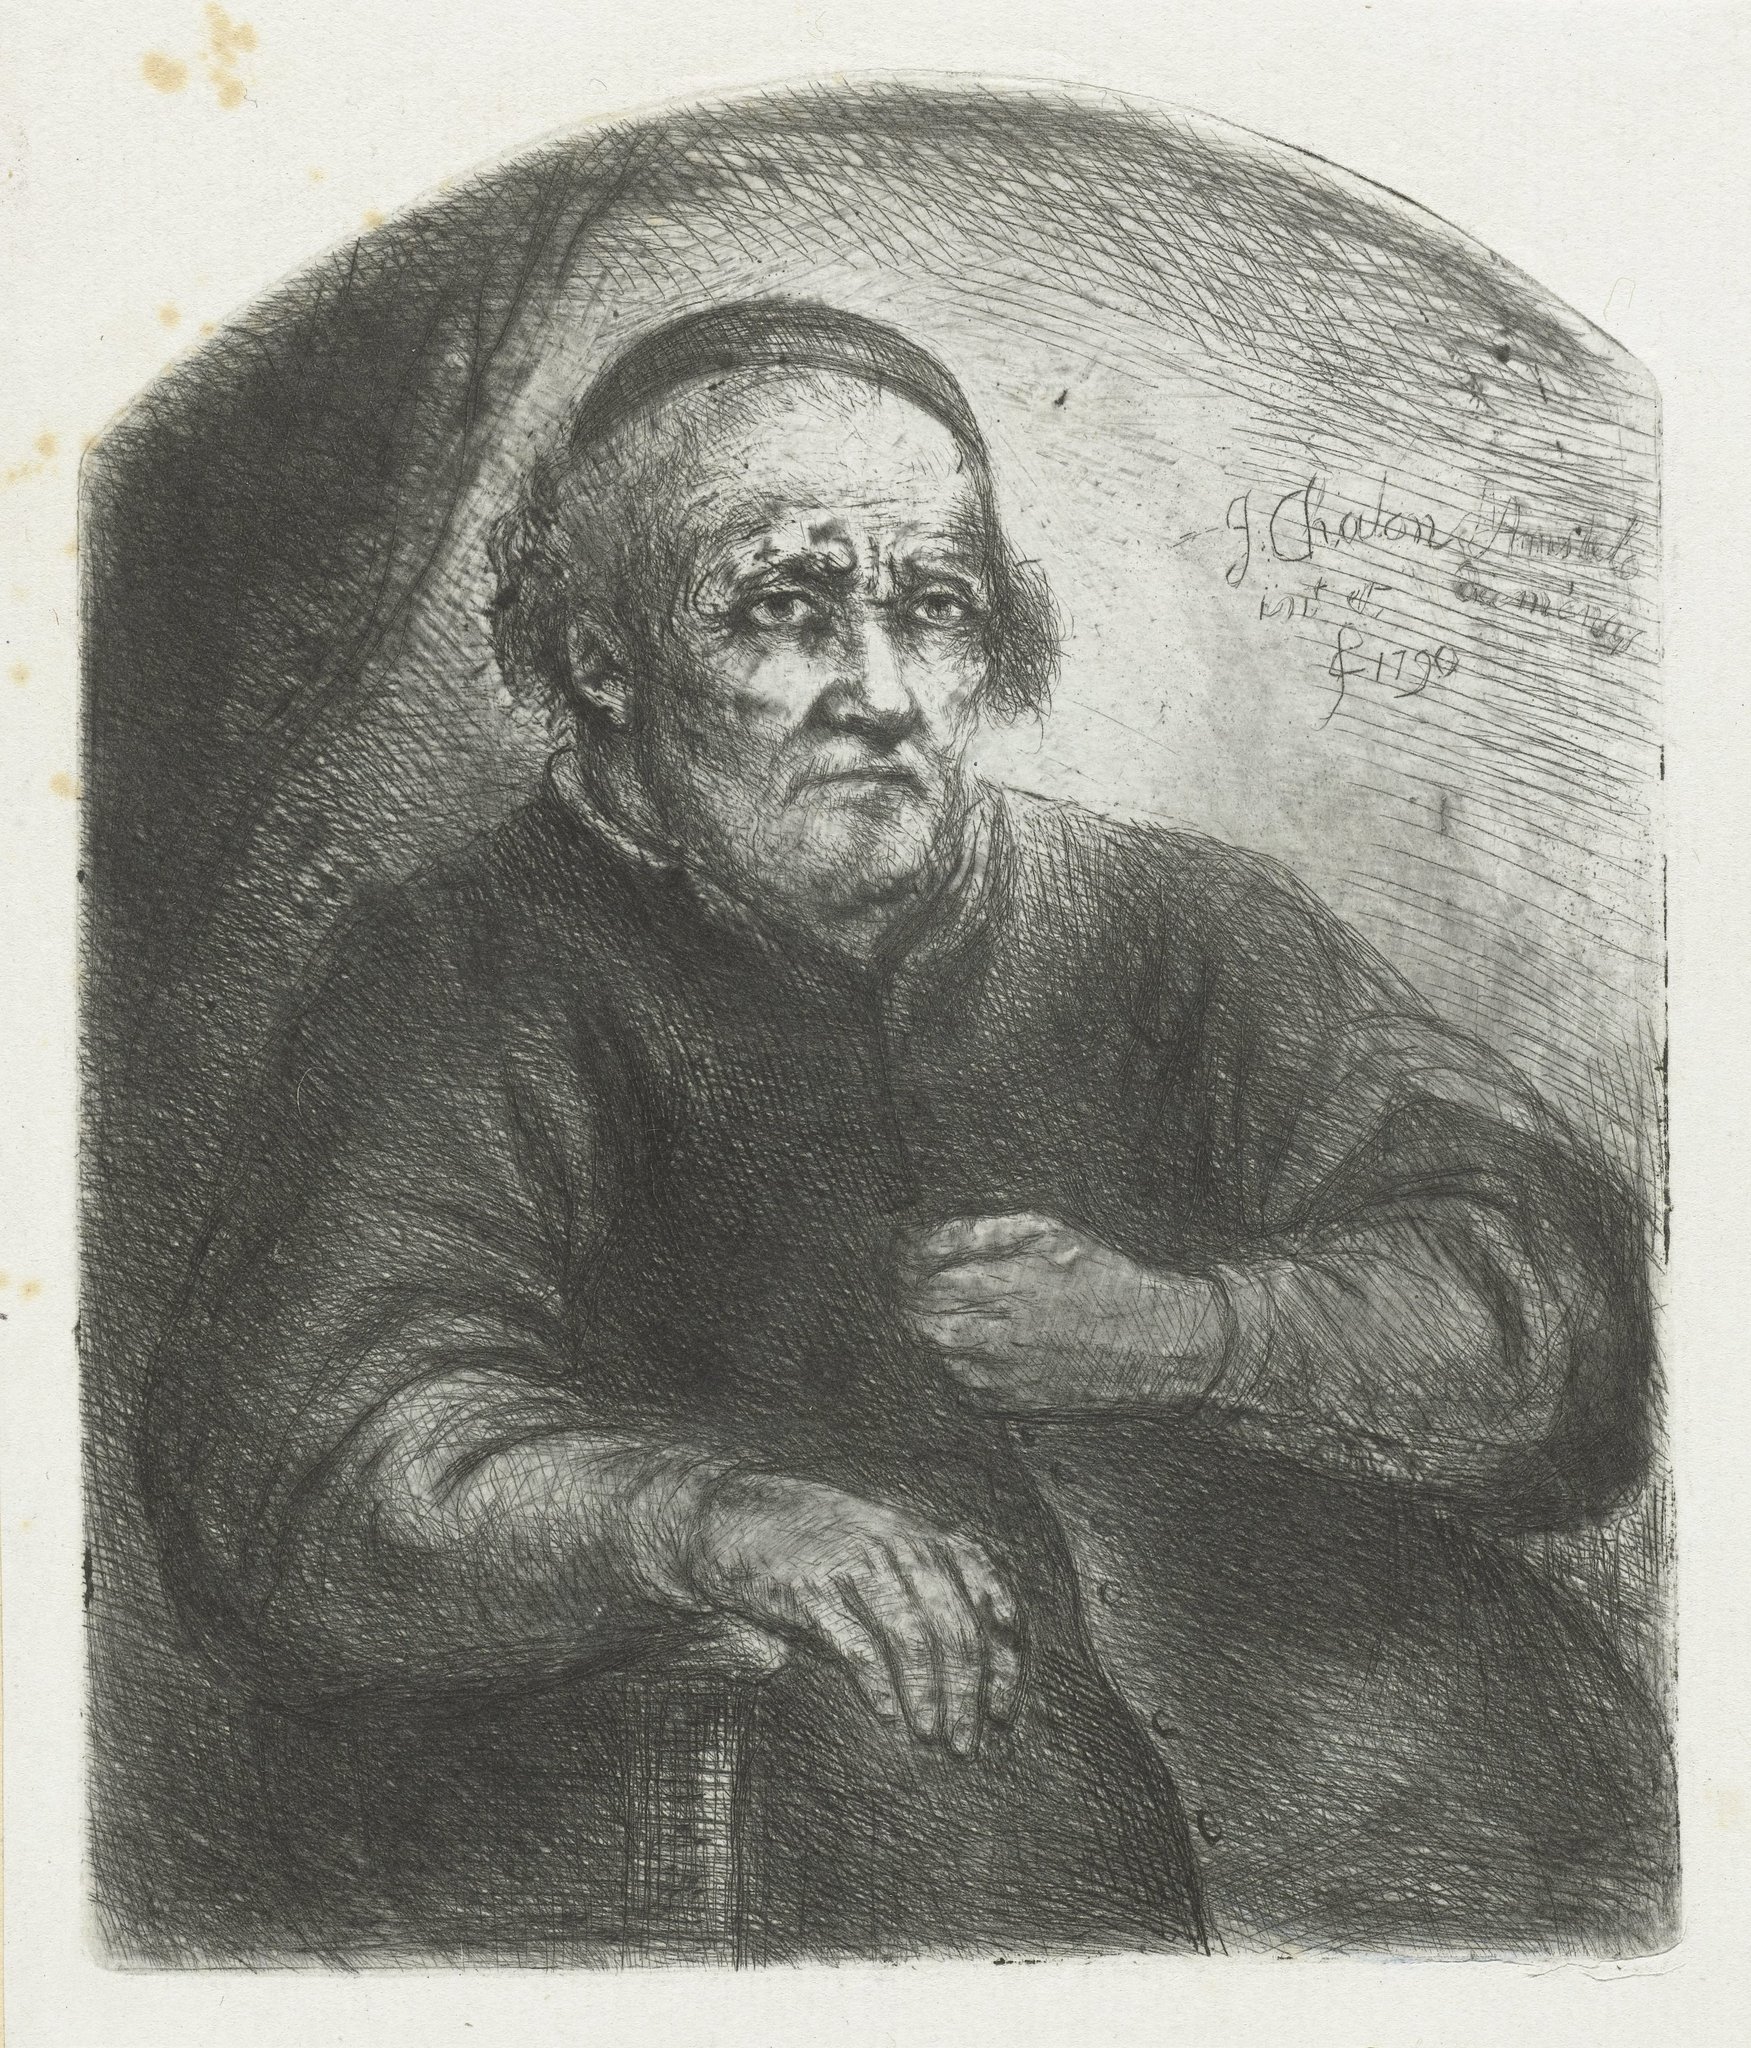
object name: print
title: Oude man in een leunstoel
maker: jan chalon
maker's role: print maker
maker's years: 1738-1795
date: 1790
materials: paper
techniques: drypoint, etching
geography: northern netherlands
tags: morphology of human expression (+ old male (human being))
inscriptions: collector's mark: Lugt 924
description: Raamvormige lijst met een oude man in een leunstoel. Buste naar rechts.